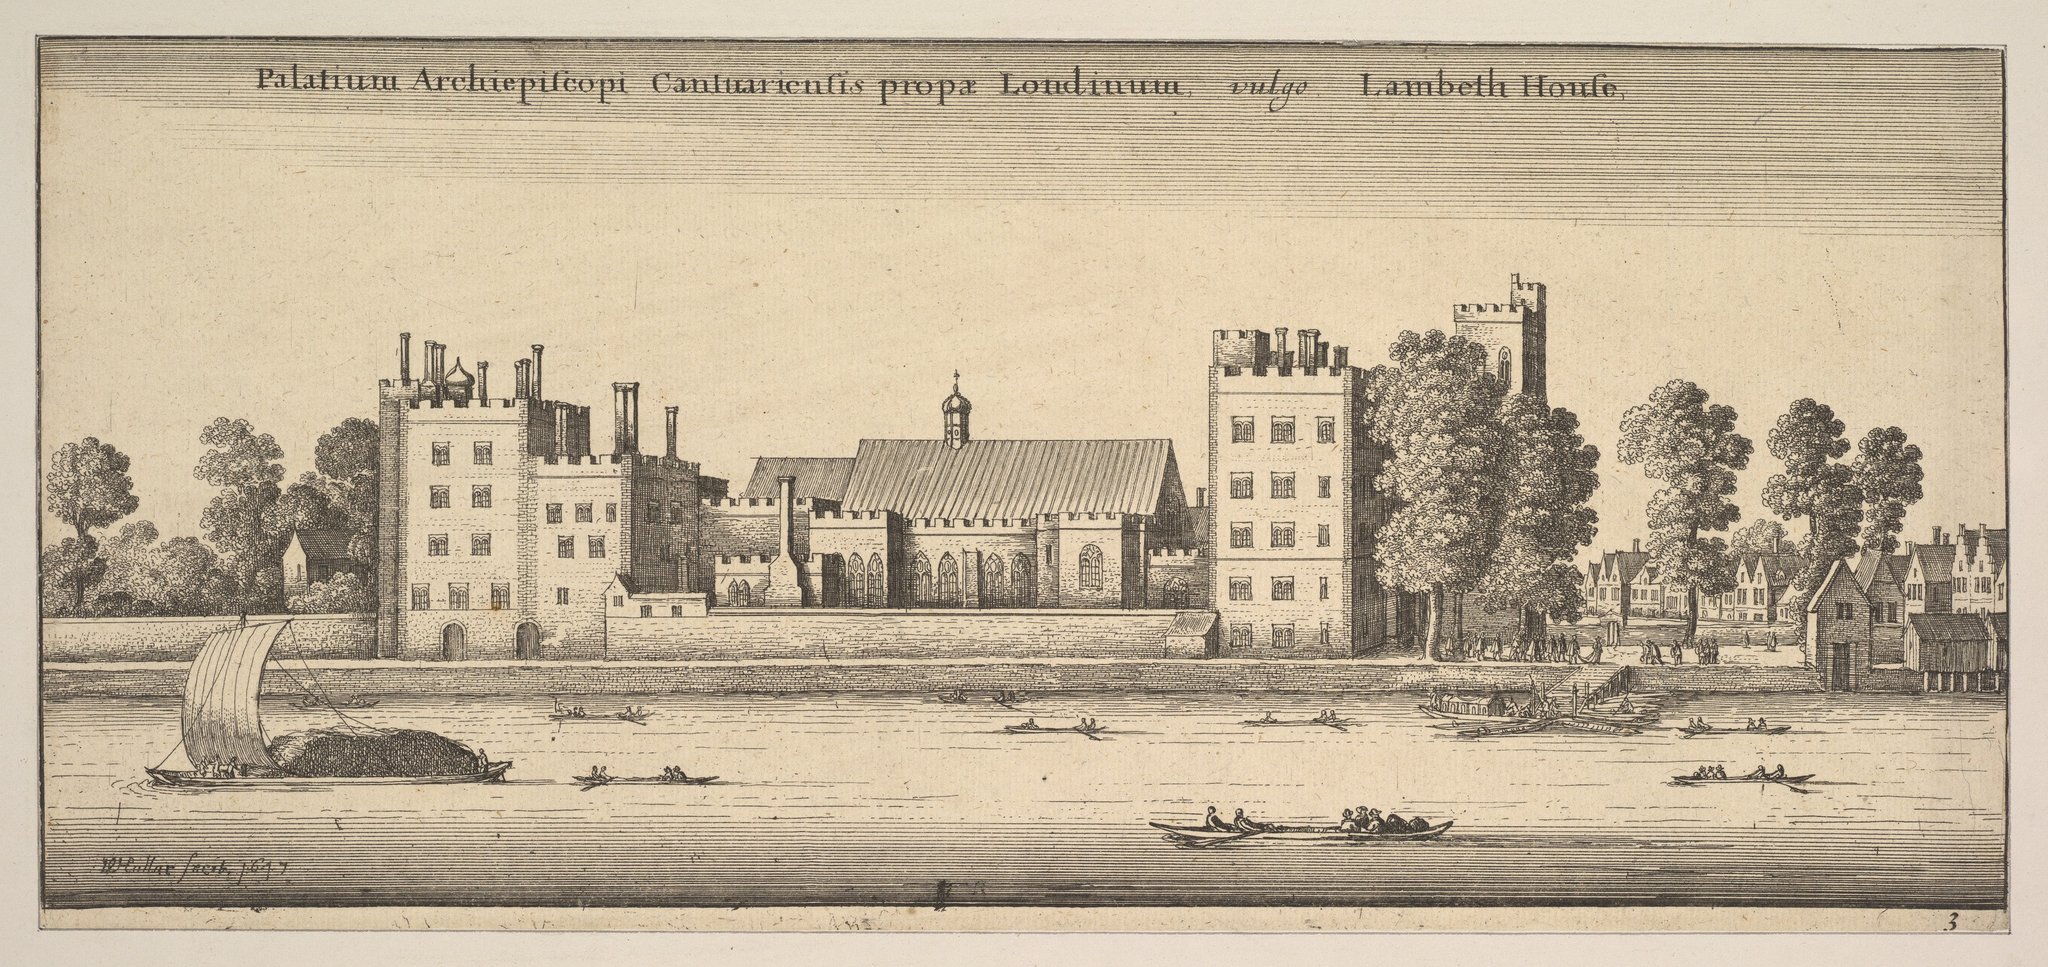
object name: print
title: Palatium Archiepiscopi Cantuariensis propae Londinum vulgo Lambeth House (Lambeth House: Palace of the Archbishop of Canterbury, London)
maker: wenceslaus hollar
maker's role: artist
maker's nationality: bohemian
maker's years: 1607-1677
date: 1647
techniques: etching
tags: palaces,boats,london